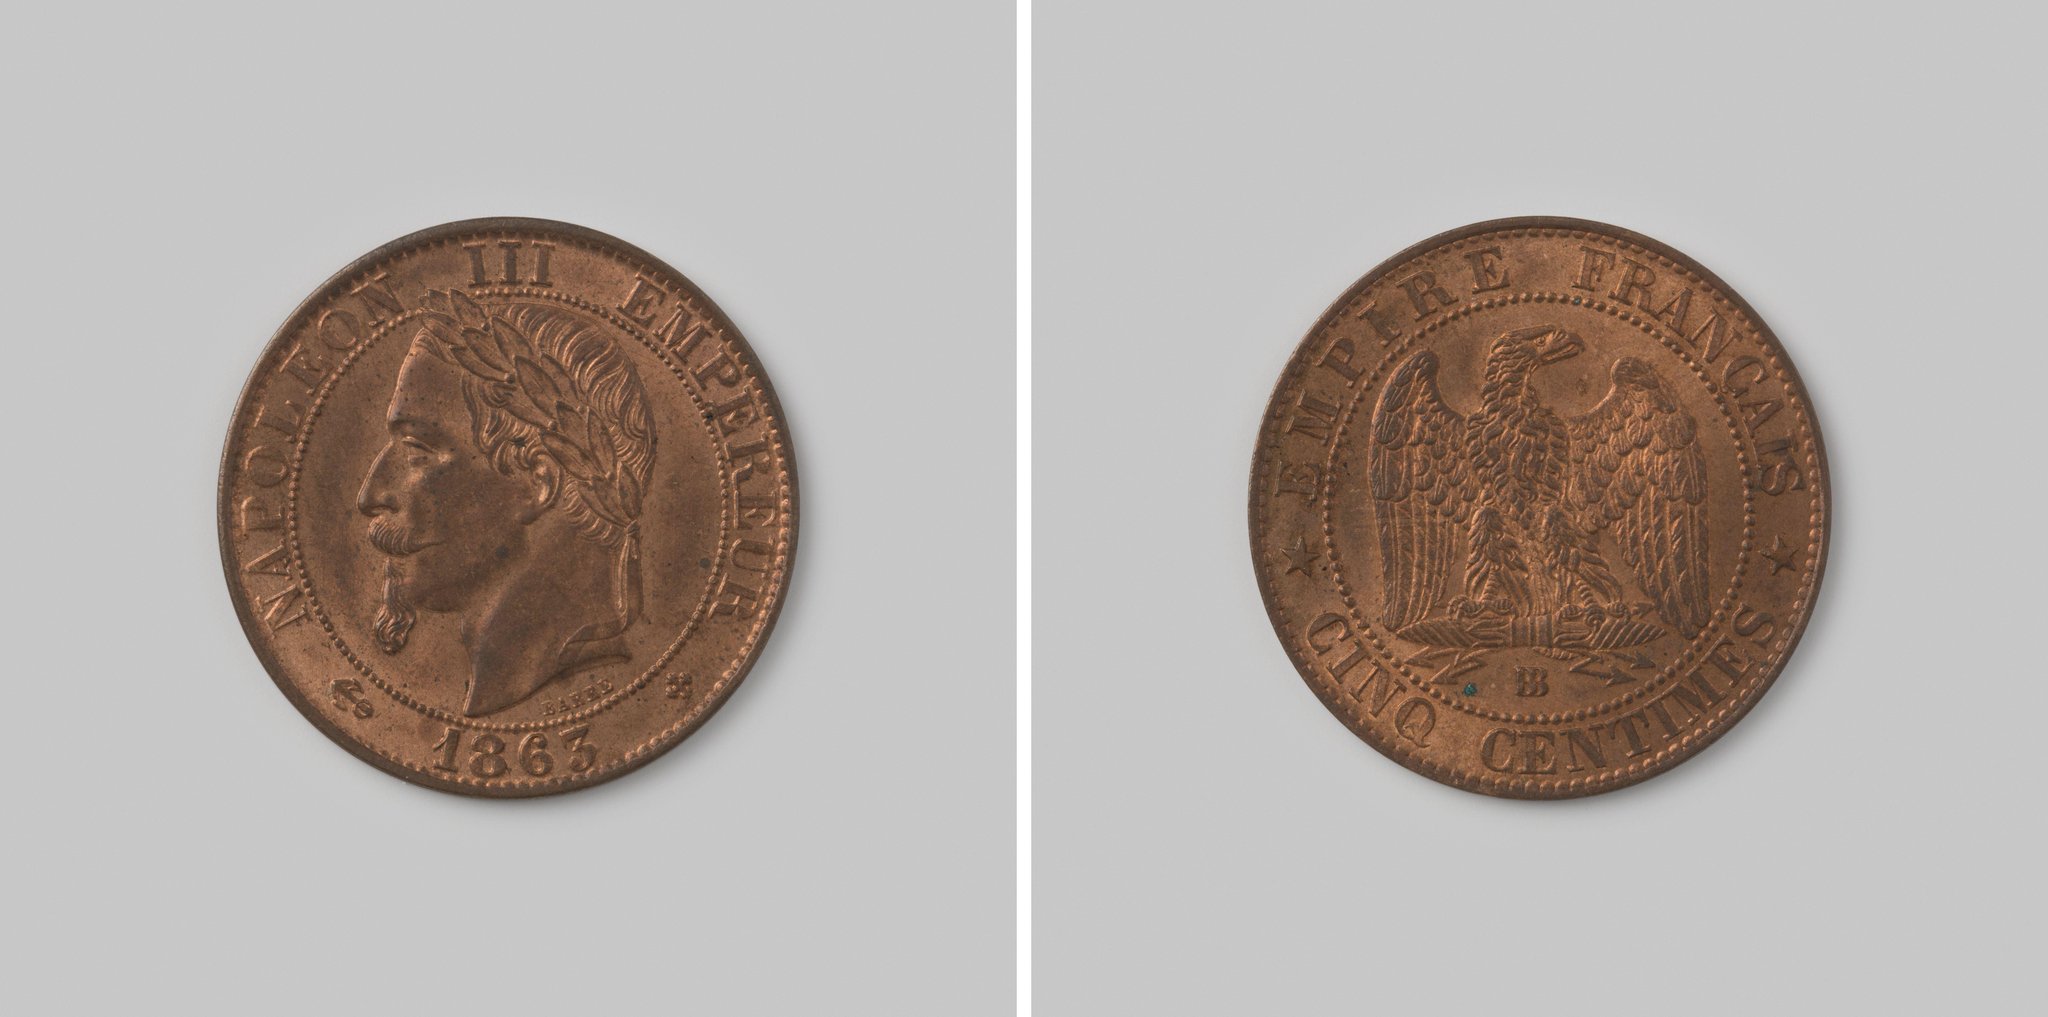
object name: coin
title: 5 centimes uit het keizerrijk Frankrijk van Napoleon III, 1863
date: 1863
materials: bronze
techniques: striking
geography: straatsburg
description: Bronzen munt. Voorzijde: gelauwerd hoofd van de keizer naar links. Jaartal onderaan. Keerzijde: op bundel, waaruit bliksemschichten, staande, naar rechts kijkende adelaar met gespreide vleugels, waaronder de letters BB [=Straatsburg]. Waarde-aanduiding onderaan in omschrift. Gladde rand.